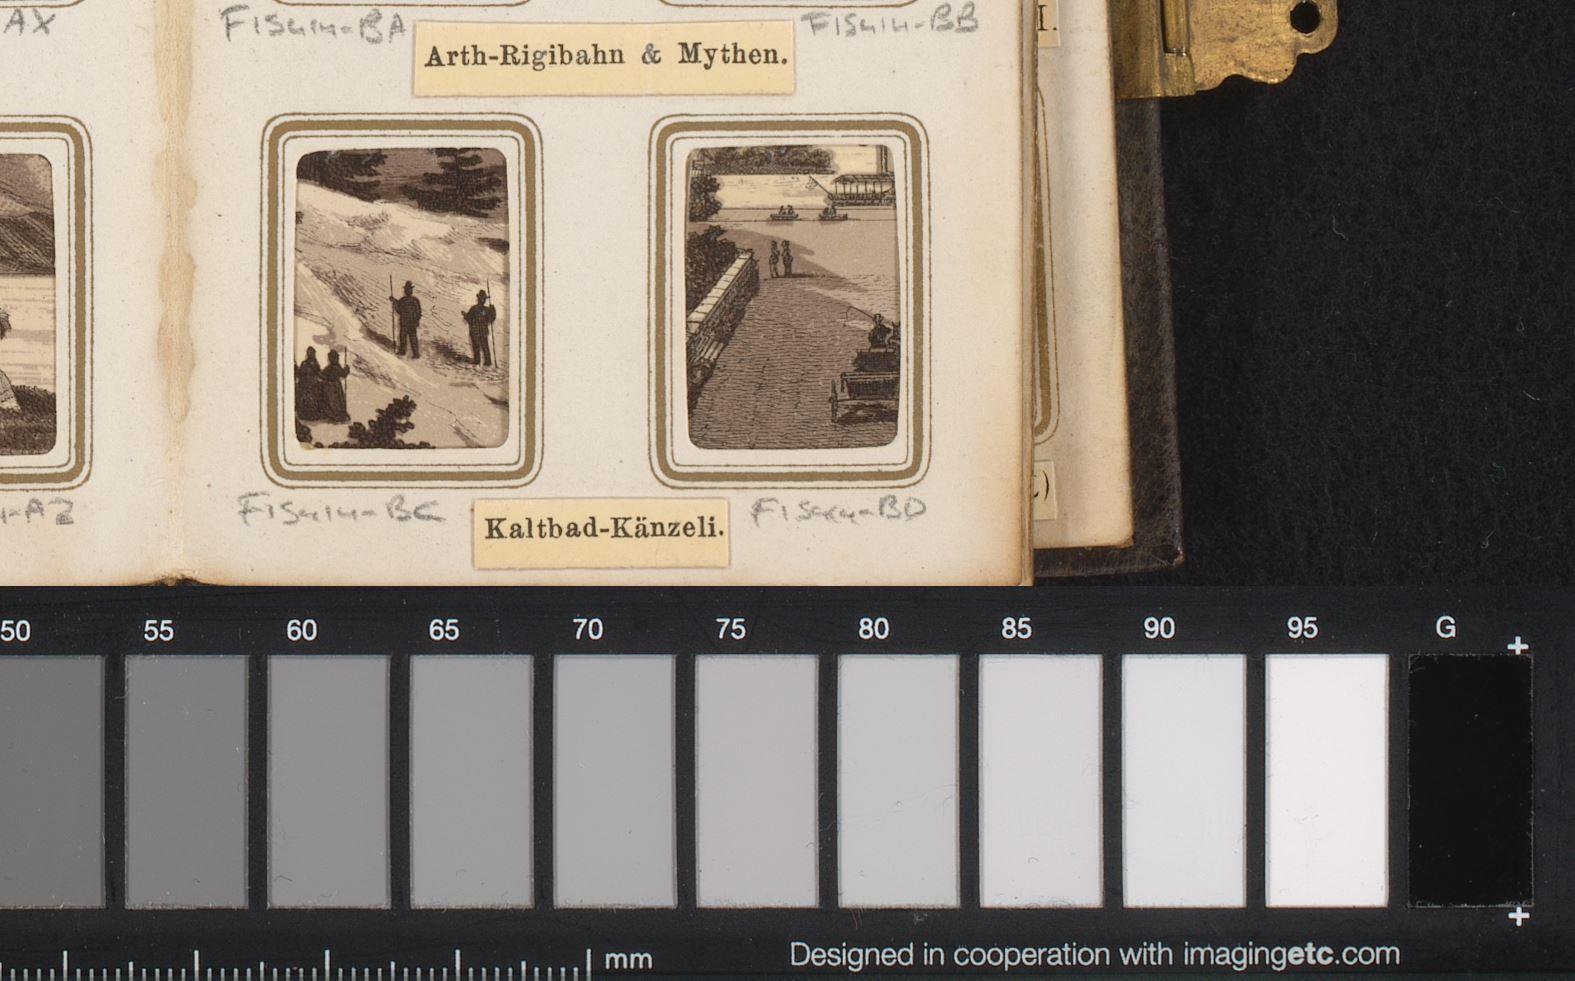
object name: album leaf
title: Straat in Rigi Kaltbad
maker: Anonymous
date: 1851-1910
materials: paper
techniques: lithograph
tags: street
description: Deze prent maakt deel uit van een album.